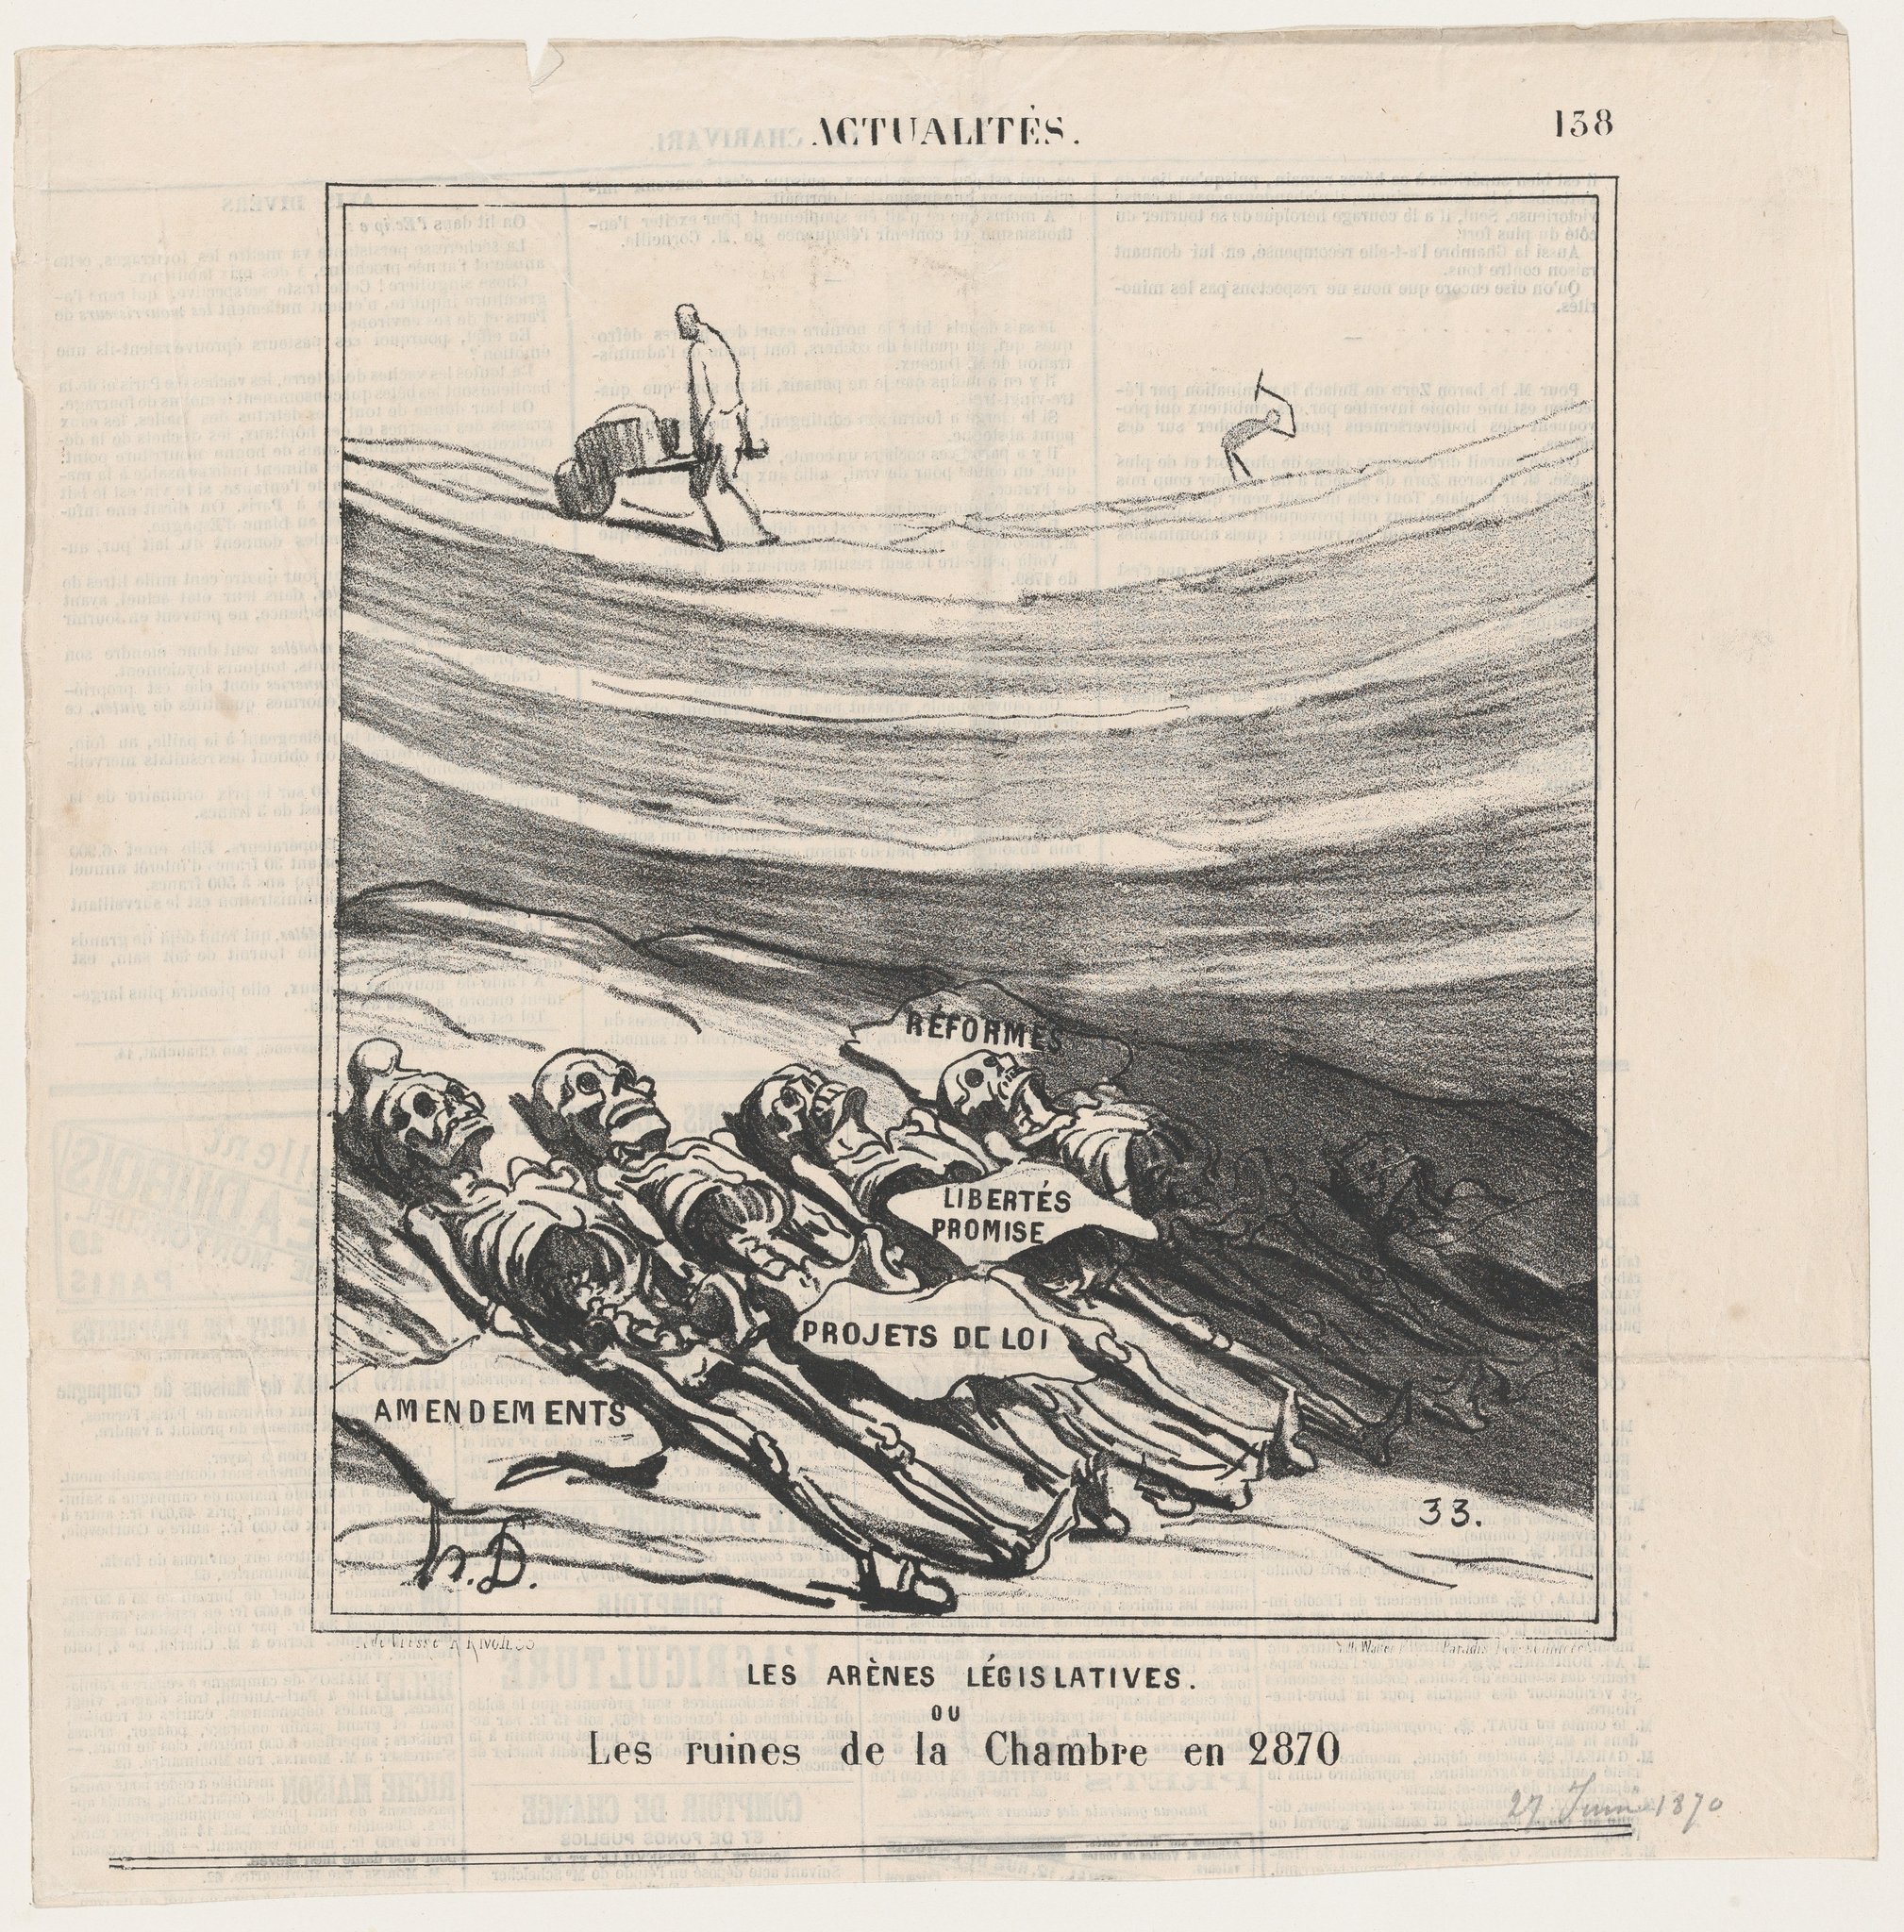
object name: print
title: The legislative arena or the ruins of the Chamber of Deputies in the year 2870, from 'News of the day,' published in Le Charivari, June 27, 1870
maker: honoré daumier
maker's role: artist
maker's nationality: french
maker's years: 1808-1879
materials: paper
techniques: lithograph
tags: satire,skeletons,men,working